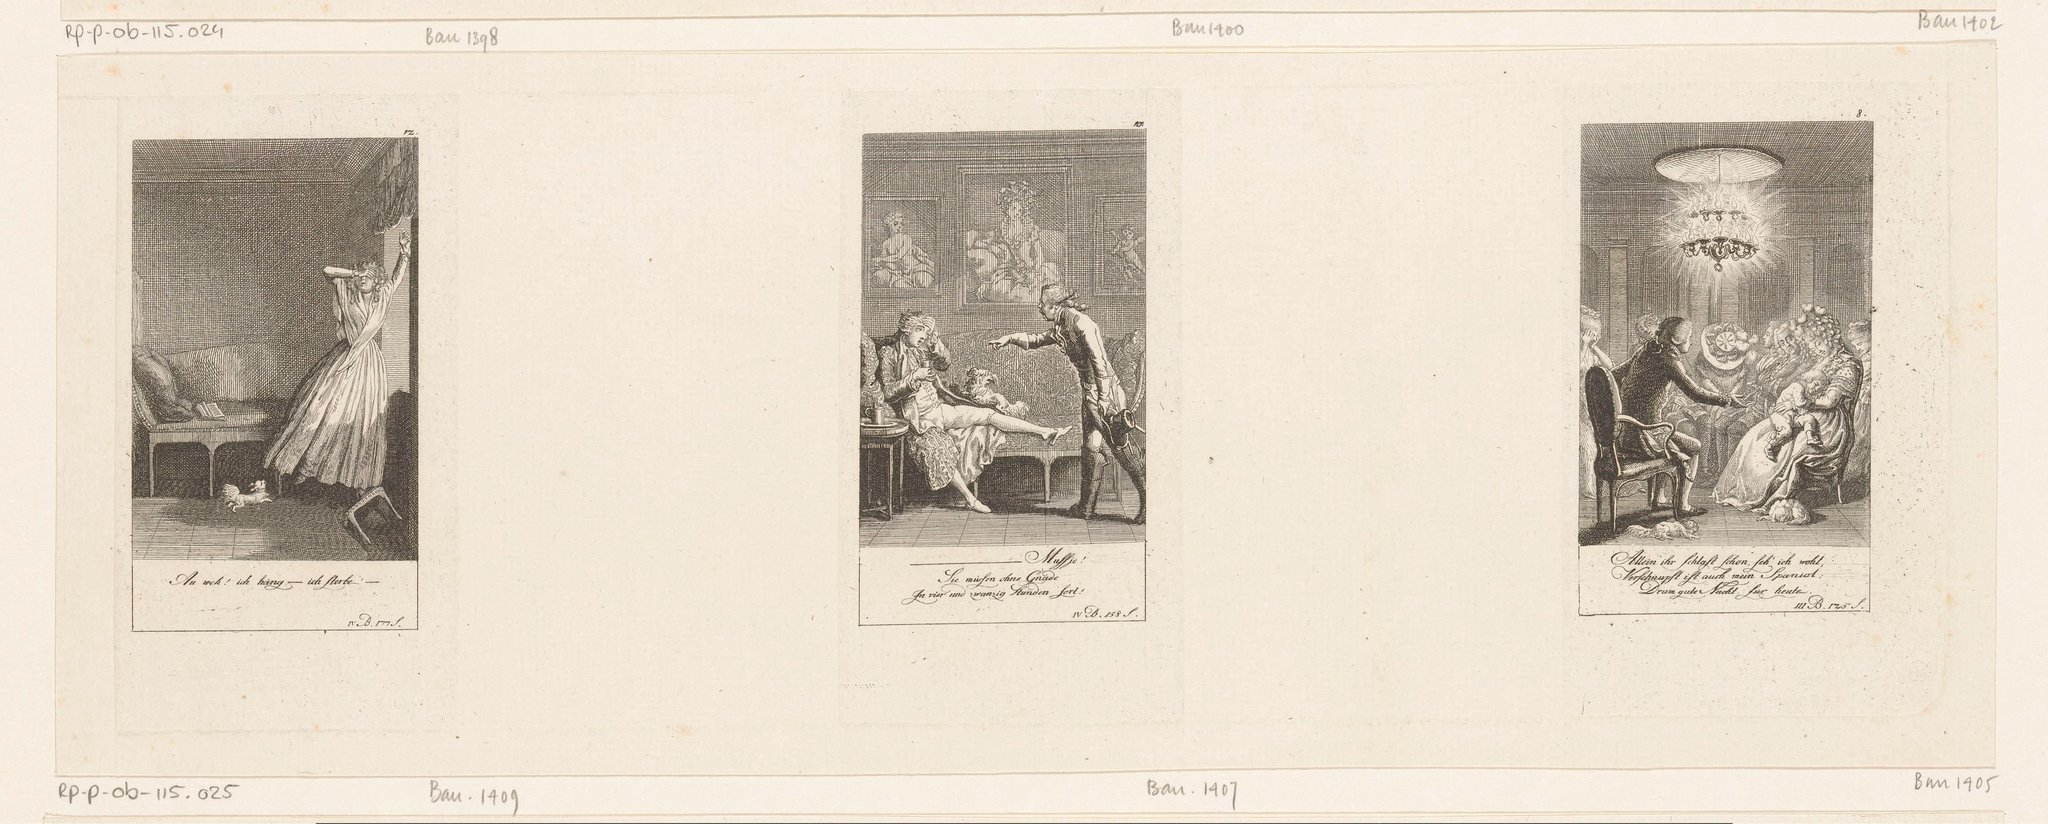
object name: book illustration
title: Drie voorstellingen uit Blumauers Aeneide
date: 1789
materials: paper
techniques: etching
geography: berlin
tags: vienna, alois blumauer, (story of) dido, literature, (story of) aeneas, family, descendance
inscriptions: collector's mark: Lugt 2228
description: Vervaardigd voor Johann Aloys Blumauers 'Aeneide'. Prenten gebruikt voor: Königl. Grossbrit. Genealogischer Kalender auf das Jahr 1790. Lauenburg: J. G. Berenberg, [1789].